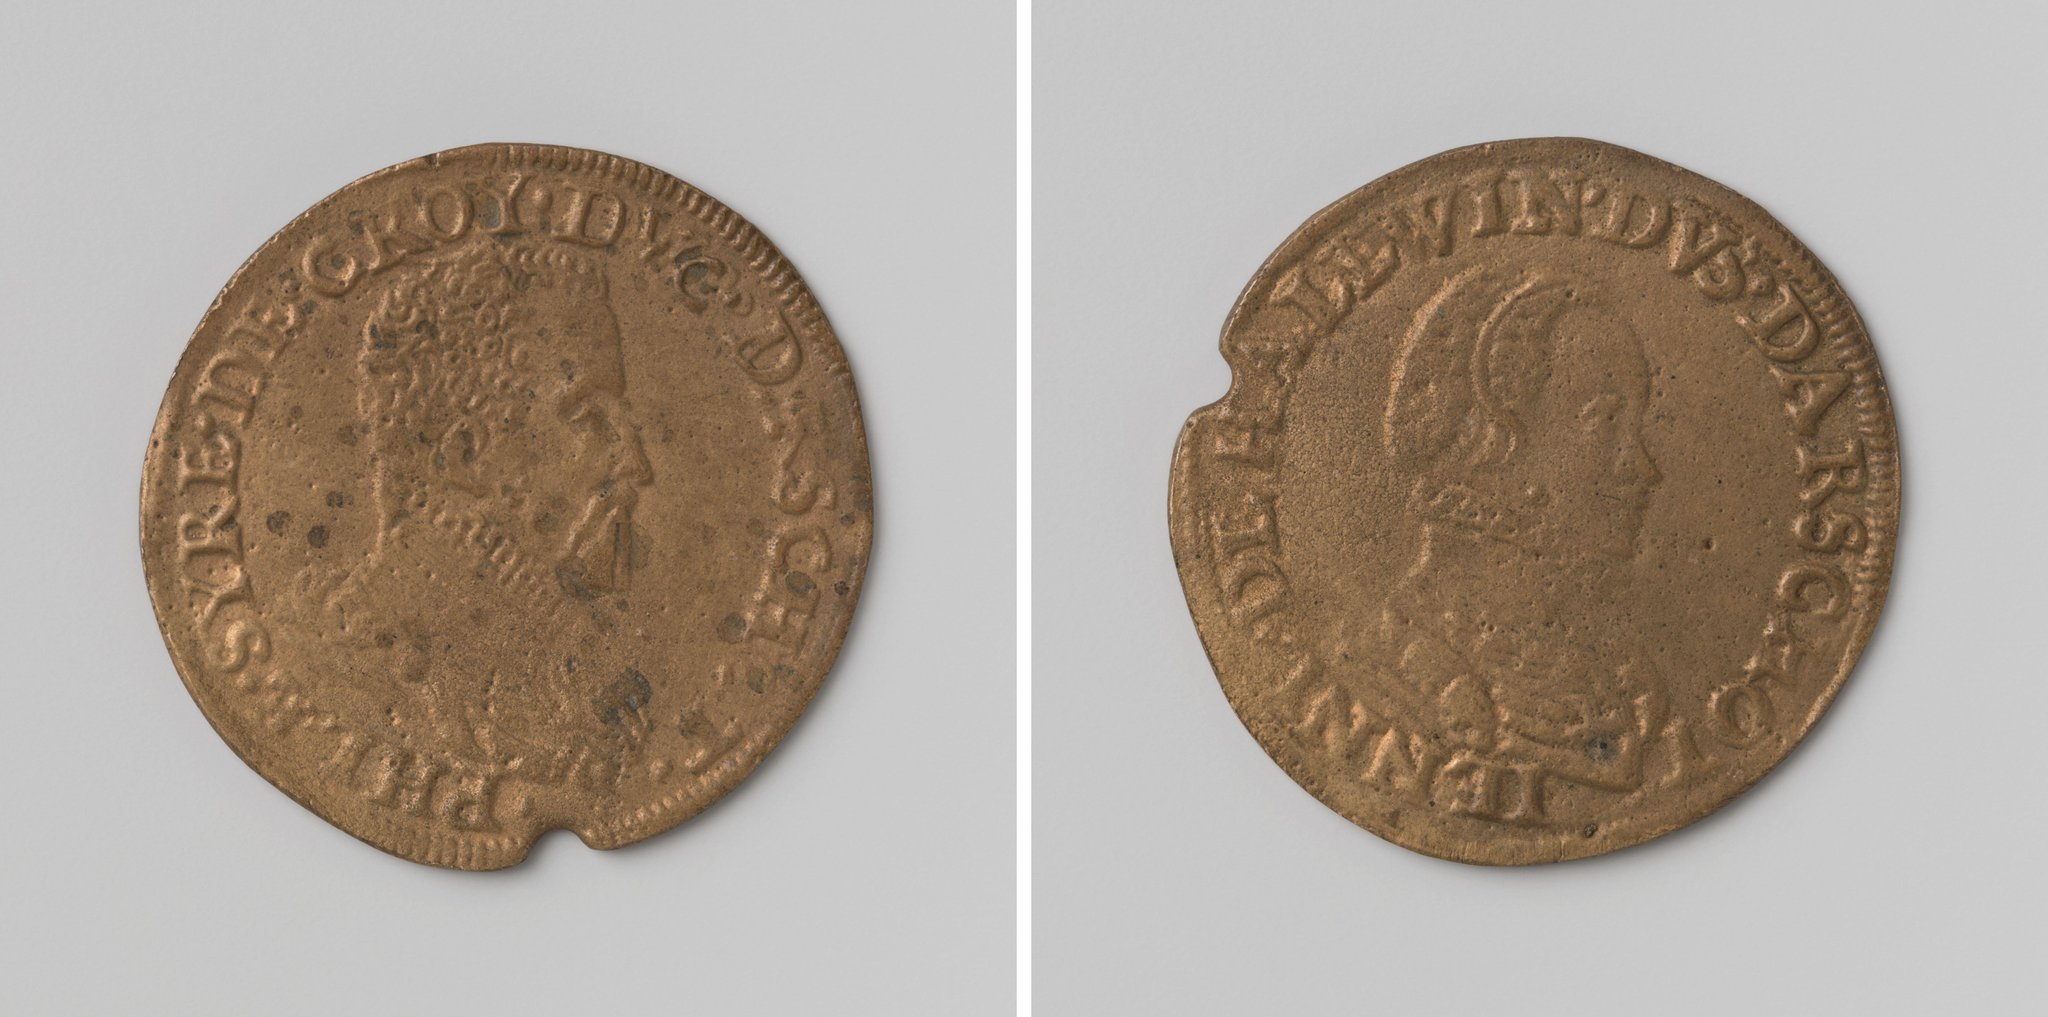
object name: jeton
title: Filips III van Croy, hertog van Aarschot en Johanna van Halewijn en Commines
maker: Anonymous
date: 1562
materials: copper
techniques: striking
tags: venice, earl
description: Koperen penning. Voorzijde: borststuk man binnen omschrift. Keerzijde: borststuk vrouw binnen omschrift